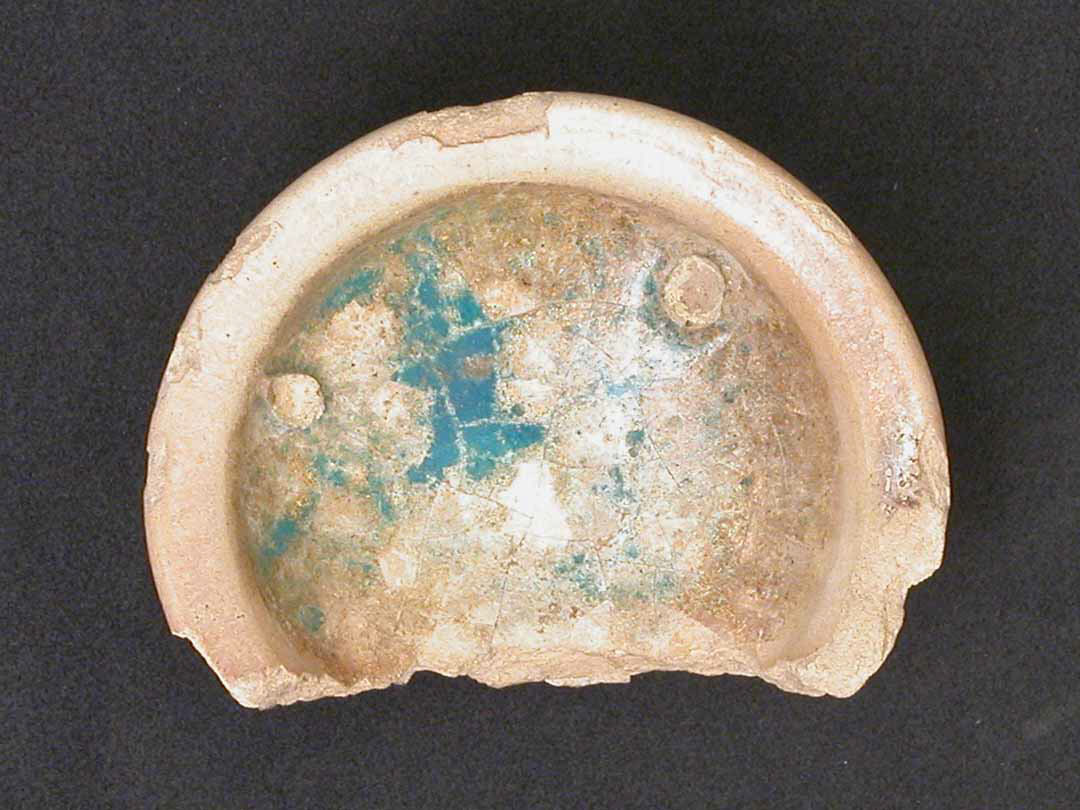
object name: bowl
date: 701-900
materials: earthenware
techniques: glazing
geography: iraq